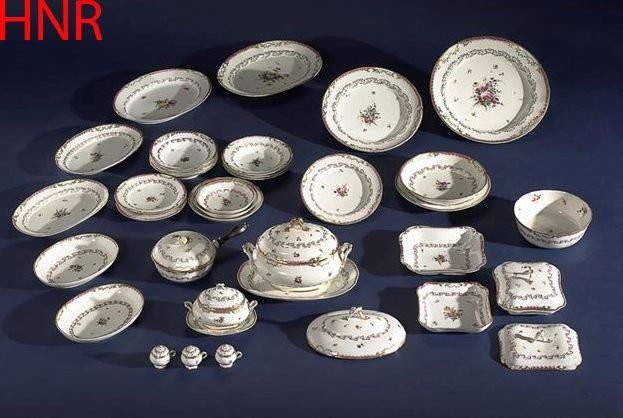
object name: plate dish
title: Bord, plat model, behorend bij een servies met geslingerd lintmotief met bladertakken, bloemboeketten en gestrooide bloemtakken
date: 1780-1820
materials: porcelain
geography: amsterdam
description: Bord, plat model, behorend bij een servies van porselein met geslingerd lintmotief in paars en goud met groene bladertakken, bloemboeketten en gestrooide bloemtakken. Randen lichtgegolfd met decoratie in goud met paars bladmotief waartussen groen gekruist bladmotief. Gemerkt: M.O.L. of AMSTEL.